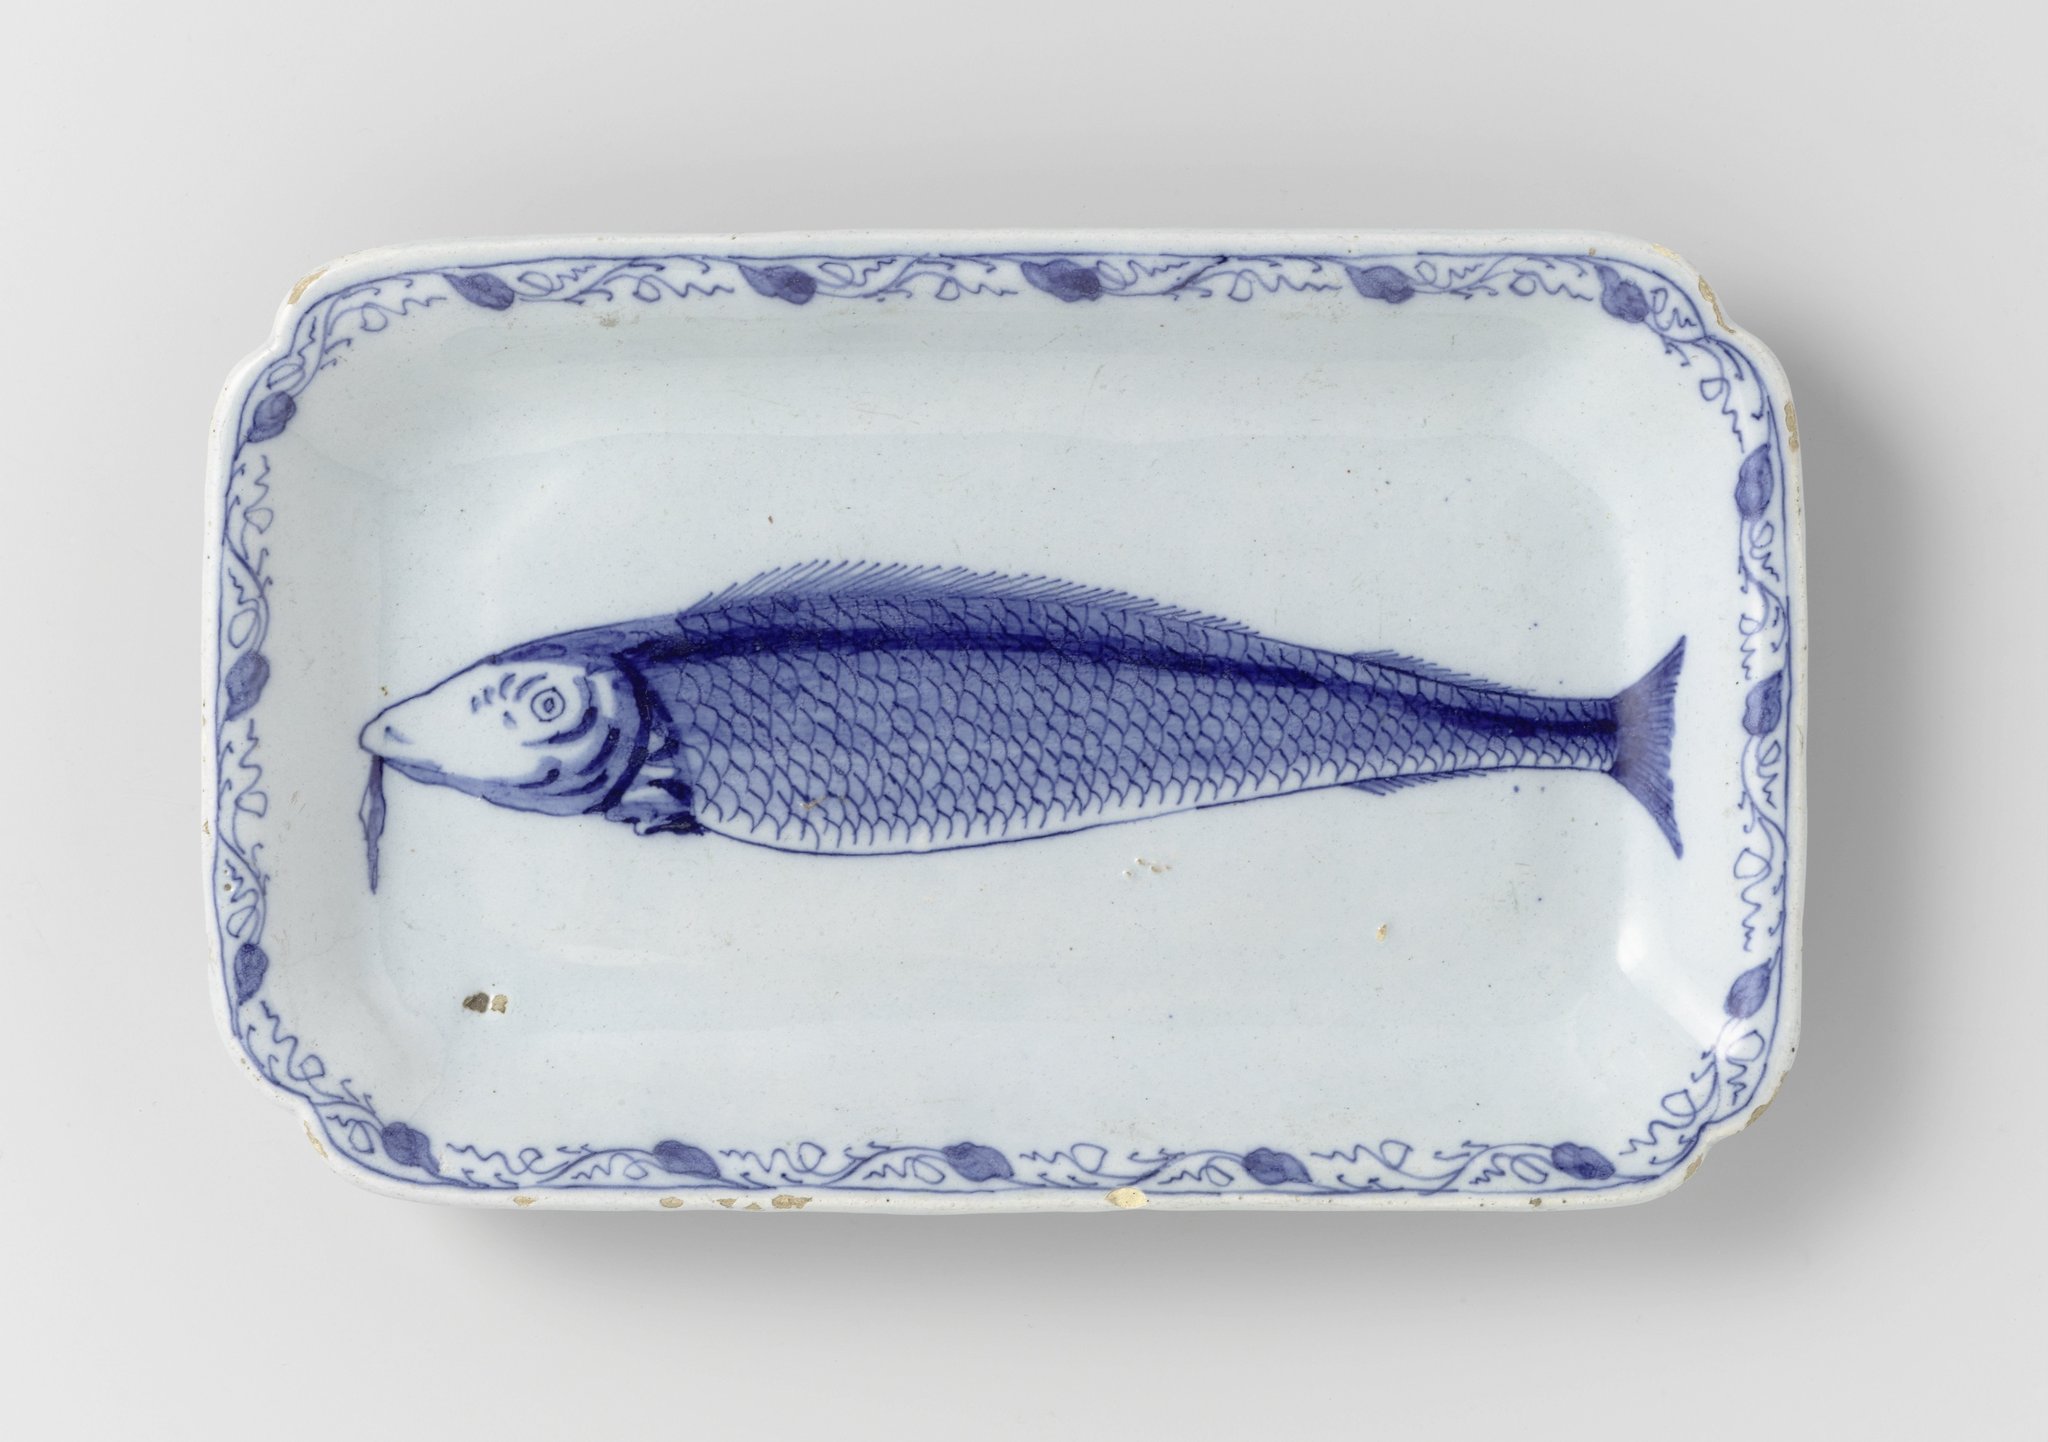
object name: haringschaal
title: Herring dish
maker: justus brouwer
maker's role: print maker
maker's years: 1646-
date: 1760-1790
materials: earthenware, glaze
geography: delft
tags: bony fishes: herring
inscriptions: mark: ‘figuratief teken bijltje’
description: Haringschaal van faience. Blauw beschilderd met een haring.